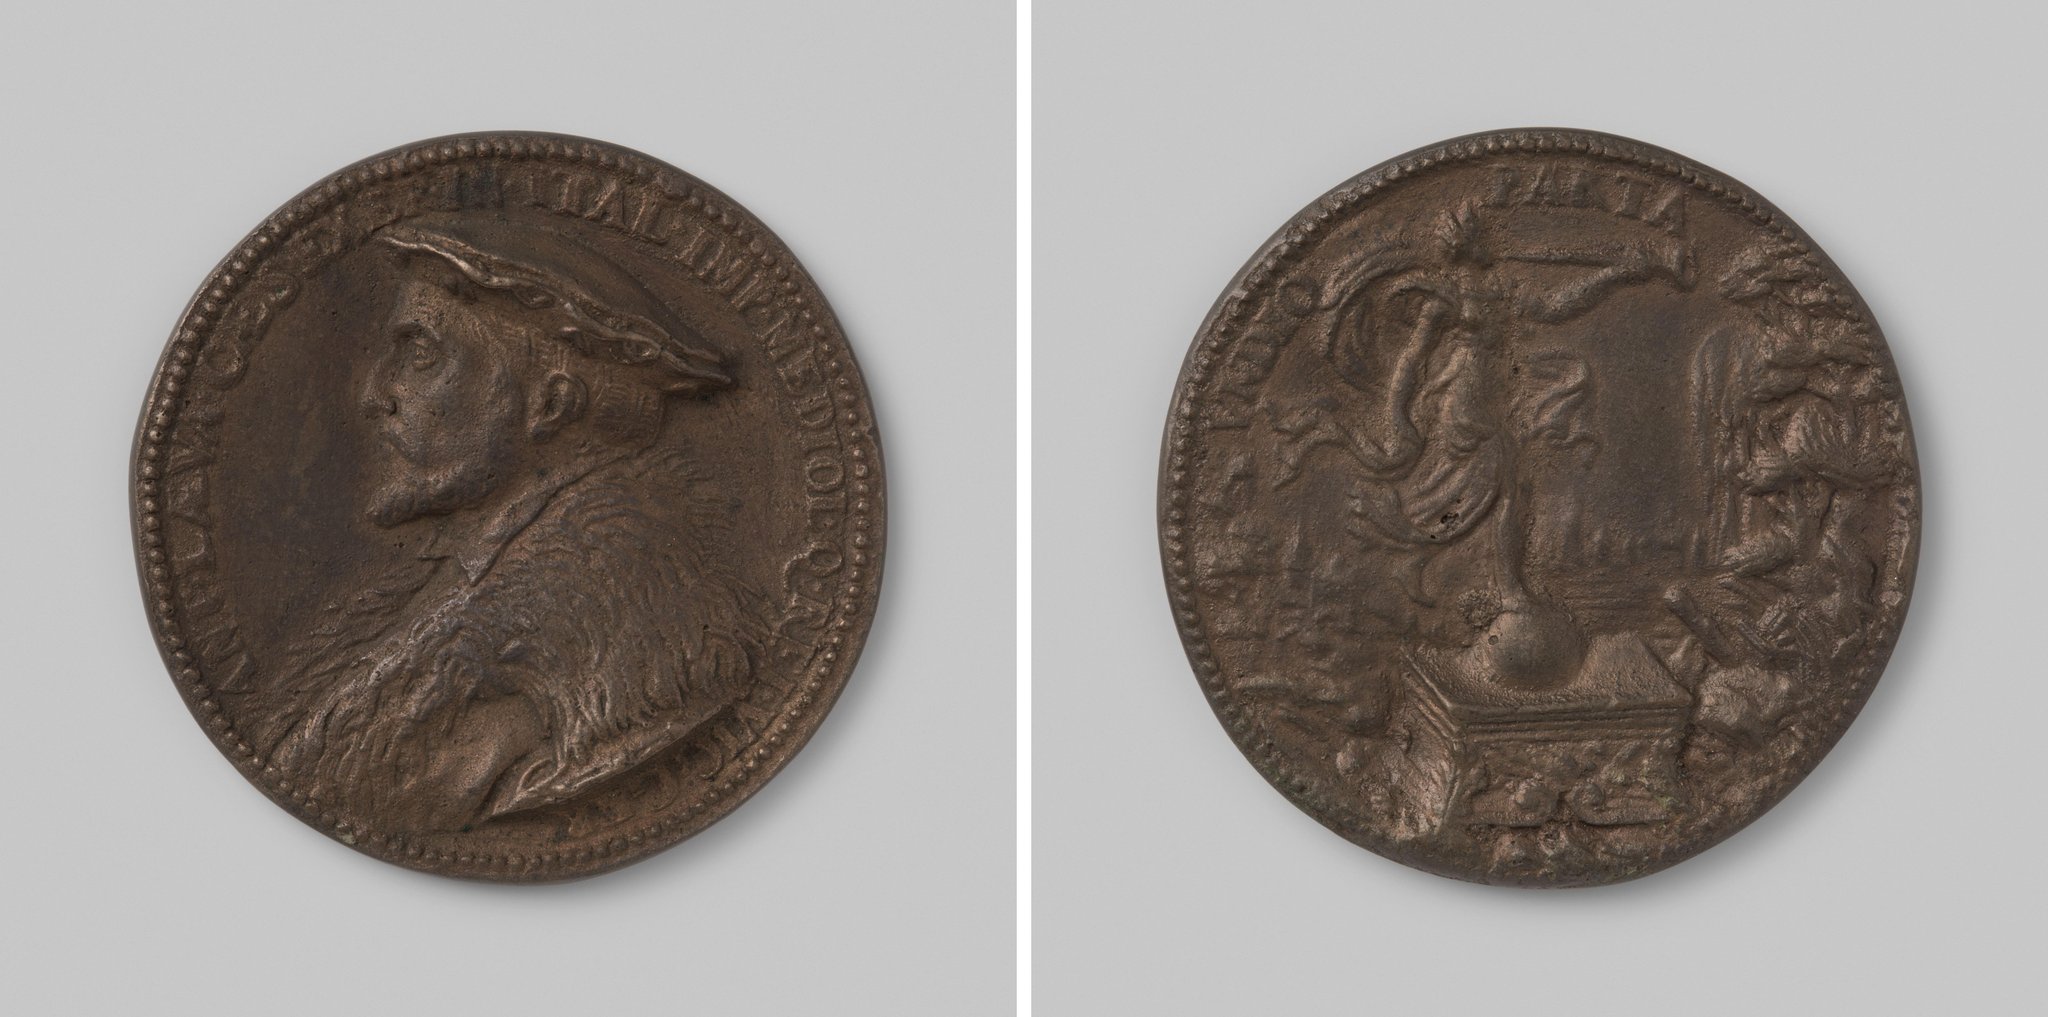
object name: history medal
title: Antonius van Leiva, bevelhebber van het leger van de keizer in Italië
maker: Anonymous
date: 1529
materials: bronze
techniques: casting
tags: antonius van leiva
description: Bronzen penning. Voorzijde: borststuk man binnen omschrift. Keerzijde: Faam, staande op bol op voetstuk, blaast op bazuin; op achtergrond gezicht op stad aan water binnen omschrift